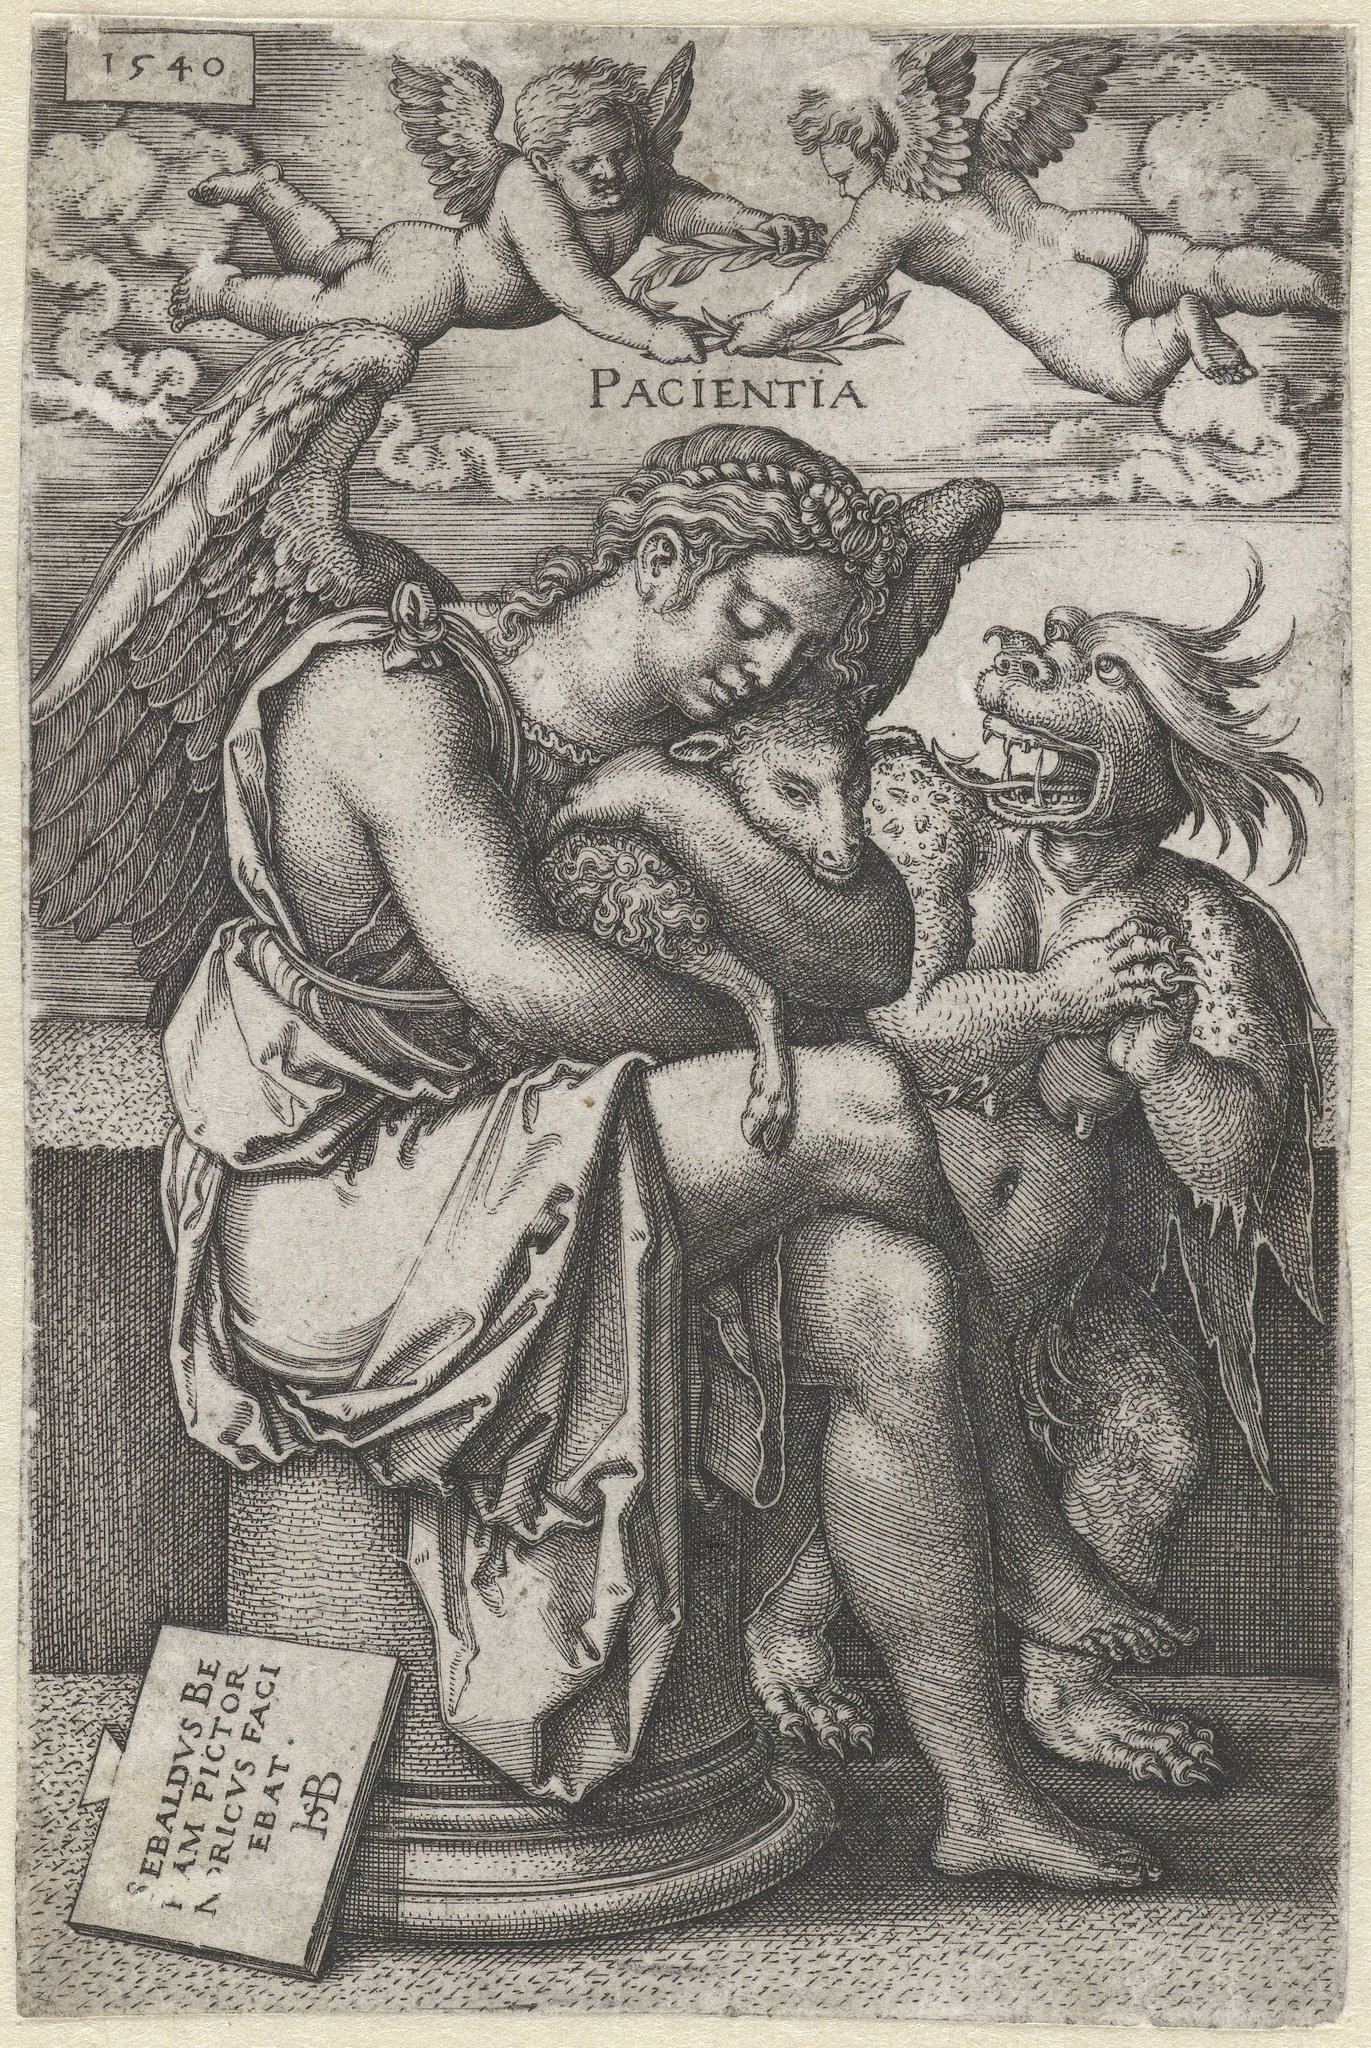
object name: print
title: Geduld (Patientia)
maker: hans sebald beham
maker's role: designer, draughtsman, print maker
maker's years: 1500-1550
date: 1540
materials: paper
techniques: engraving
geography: frankfurt am main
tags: patience; 'patienza' (ripa)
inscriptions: collector's mark: Lugt 2228a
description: Gevleugelde vrouw als personificatie van Geduld (Patientia) zittend met een lam in haar armen terwijl de duivel handenwrijvend toekijkt. De deugd krijgt van twee engelen een lauwerkrans op het hoofd geplaatst.